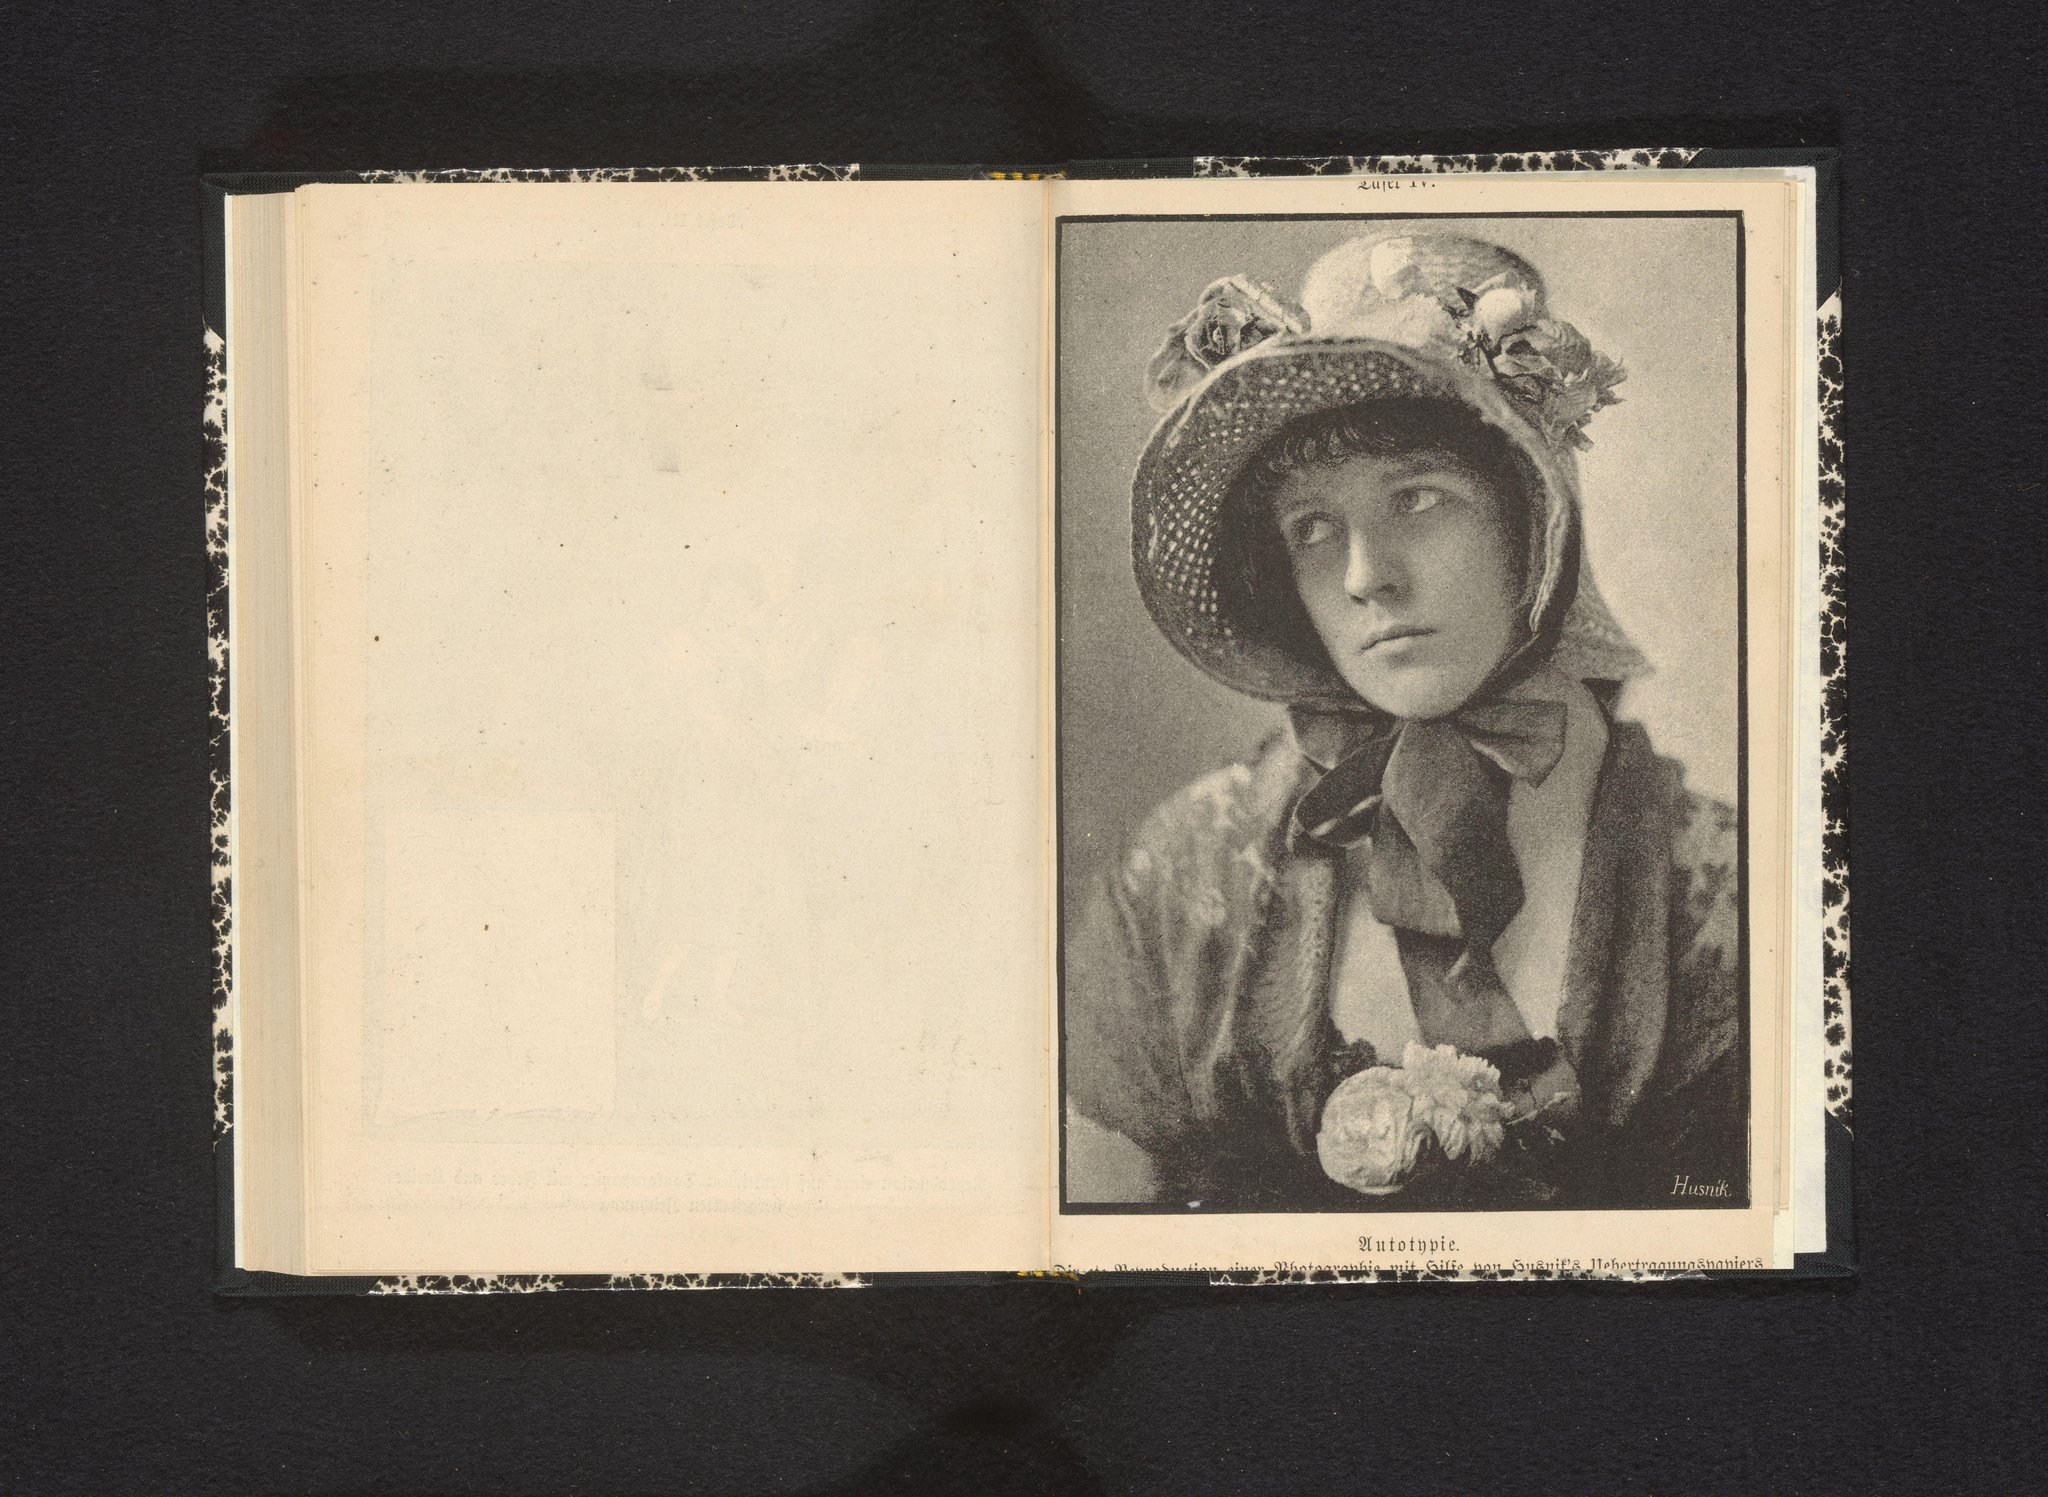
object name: page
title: Portret van een onbekende vrouw met een hoed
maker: jakub husnik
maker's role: clichémaker, fotograaf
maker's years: 1837-1916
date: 1875-1885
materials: paper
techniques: autotype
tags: adolescent, young woman, maiden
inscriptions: inscription: ‘Autotypie. [...]’, number: ‘Tafel IV.’